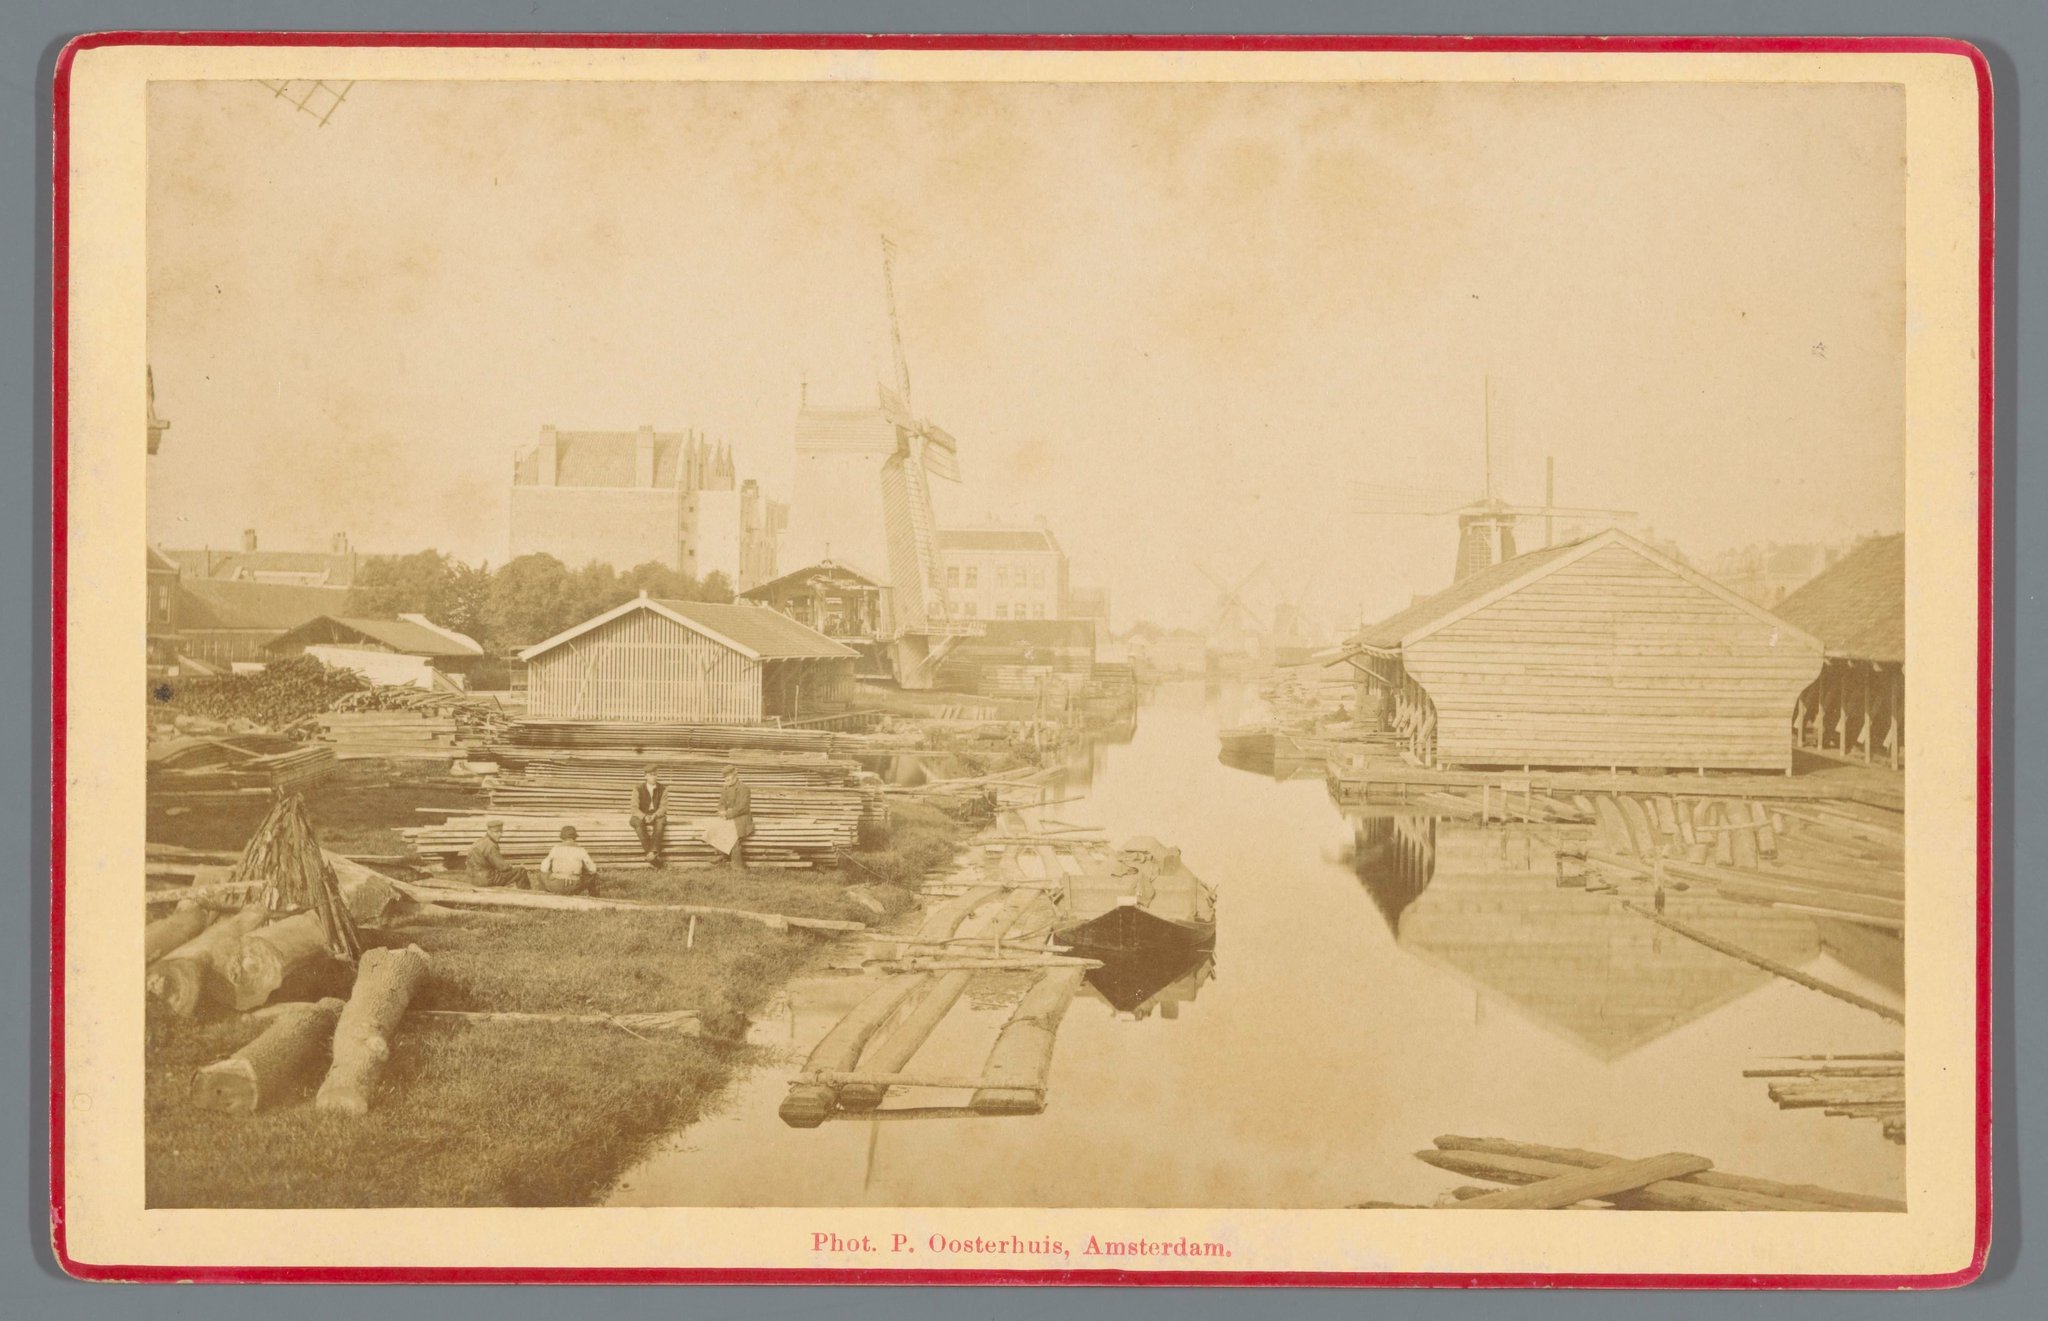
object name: cabinet photograph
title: Zaagmolensloot, Amsterdam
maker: pieter oosterhuis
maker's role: draughtsman, print maker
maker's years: 1816-1885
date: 1867-1883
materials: cardboard, paper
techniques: albumen print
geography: amsterdam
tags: saw-mill (works), windmill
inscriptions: inscription: ‘Phot. P. Oosterhuis, Amsterdam.’, inscription: ‘+ Govert Flinck/straat + gerard Doustraat/ gedempt omstreeks 1870’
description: Links de molen 'De Ooyevaar' aan het Zuidelijk Zaagmolenpad, rechts molen 'De Kievit' aan het Noordelijk Zaagmolenpad.